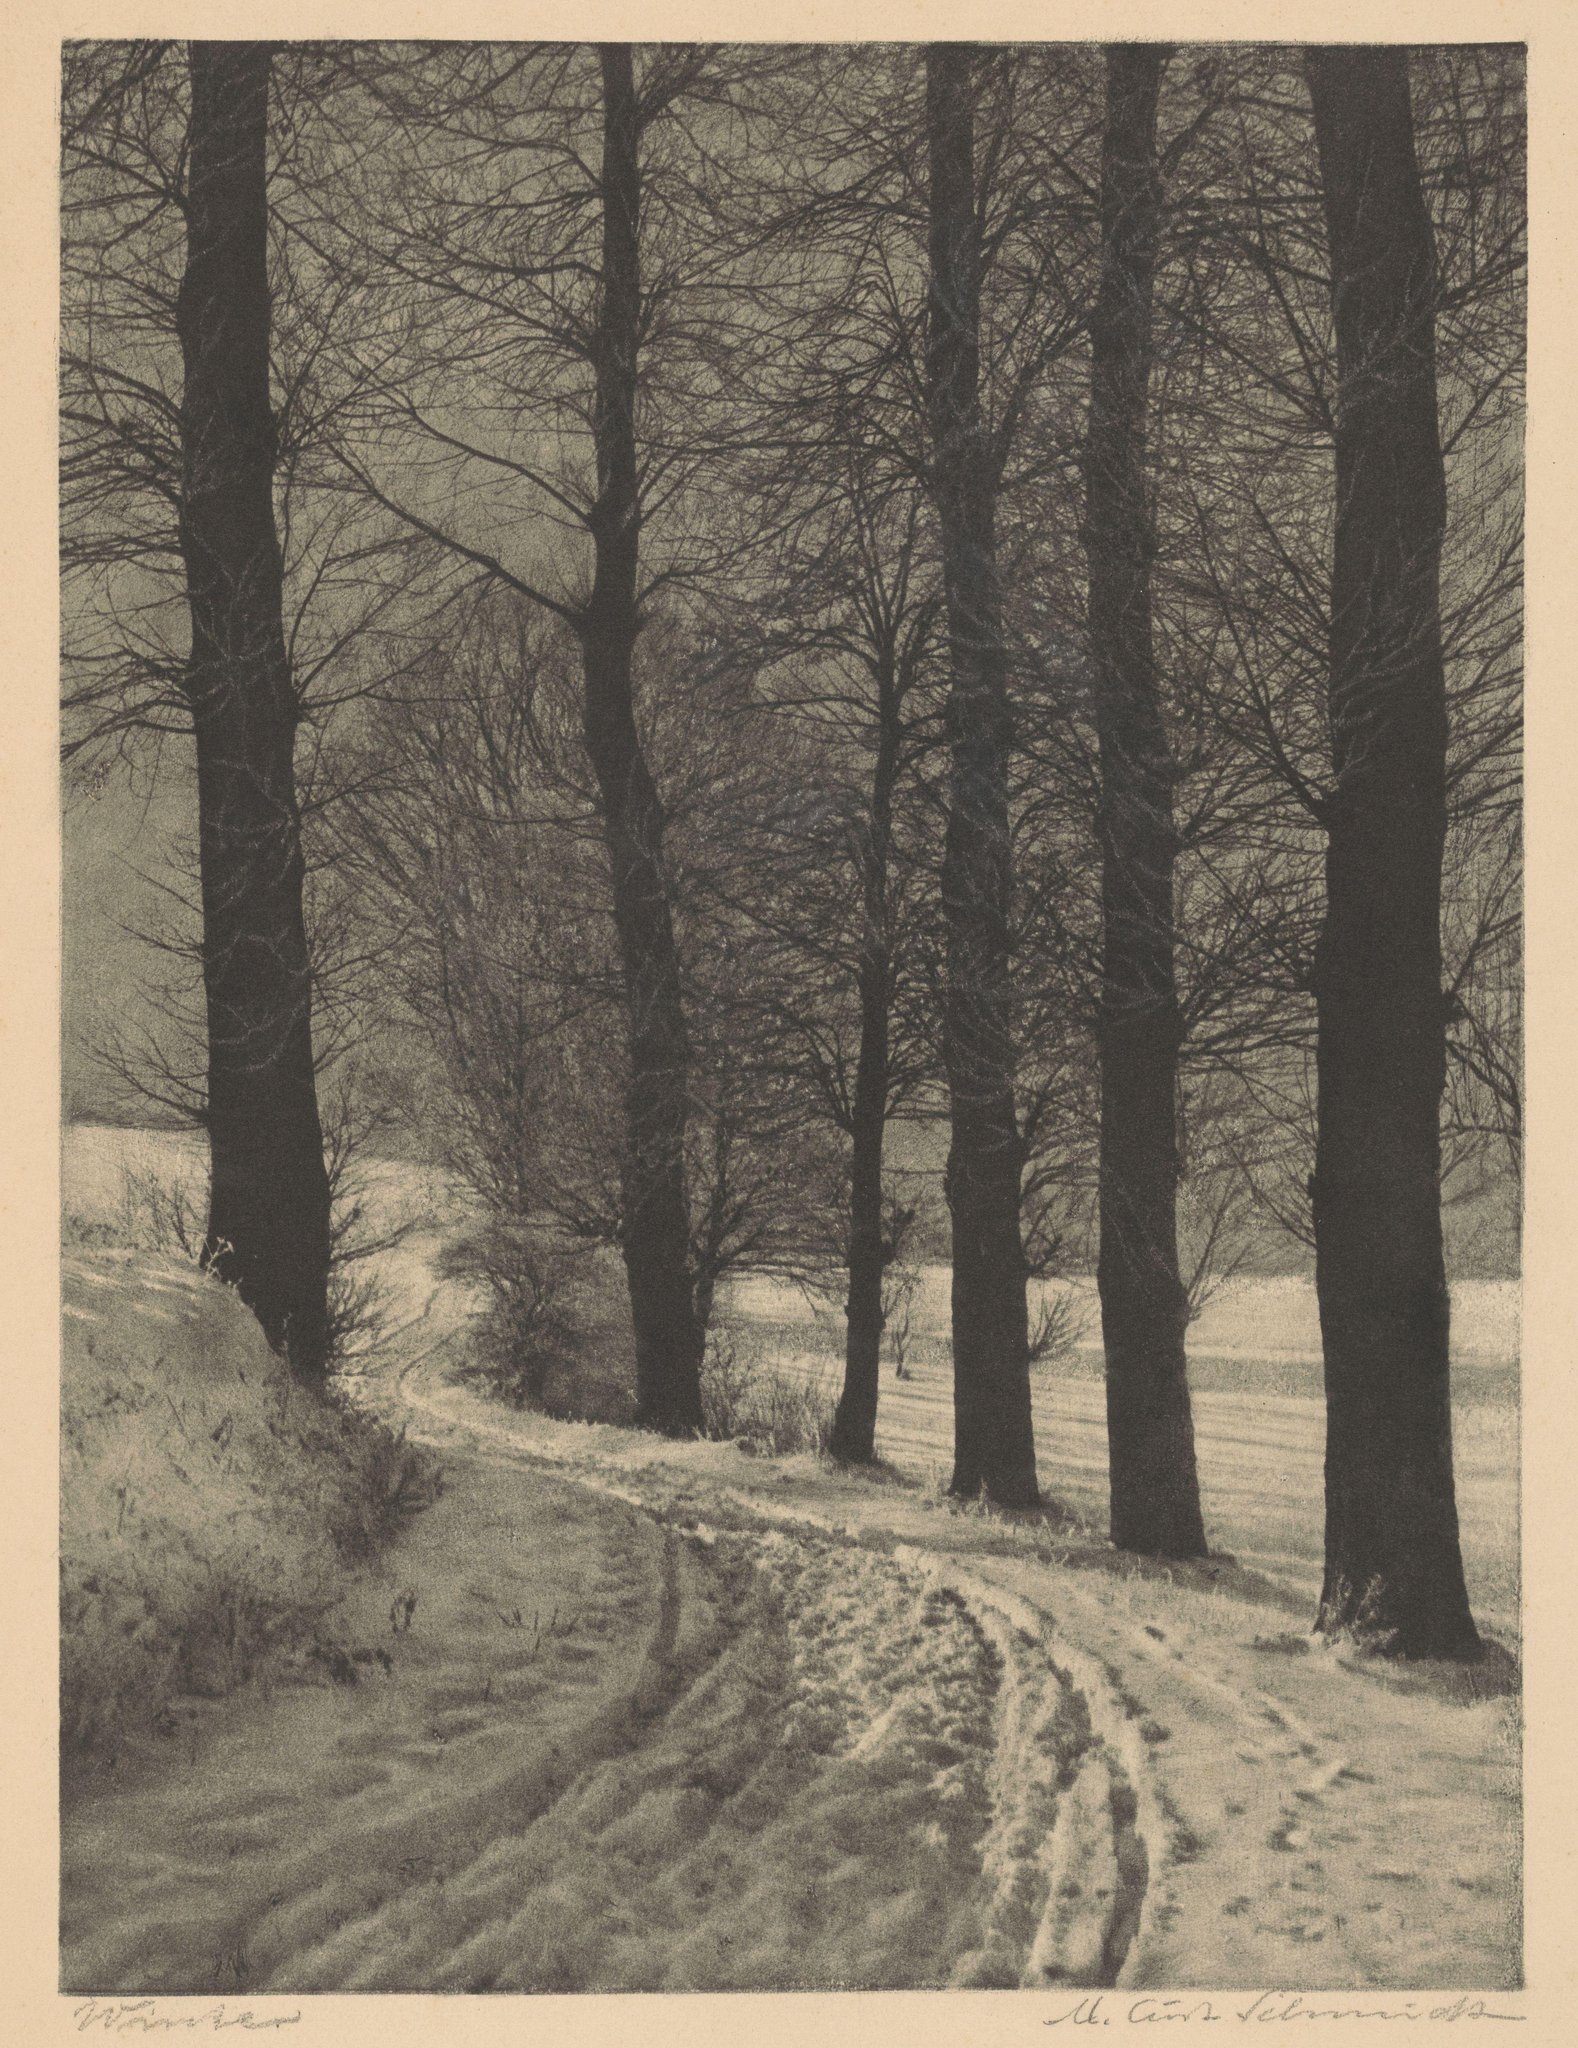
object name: photomechanical print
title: Winterlandschap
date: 1910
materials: paper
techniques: photoaquatint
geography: germany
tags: forest, wood, snow, germany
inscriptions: title: ‘Winter’